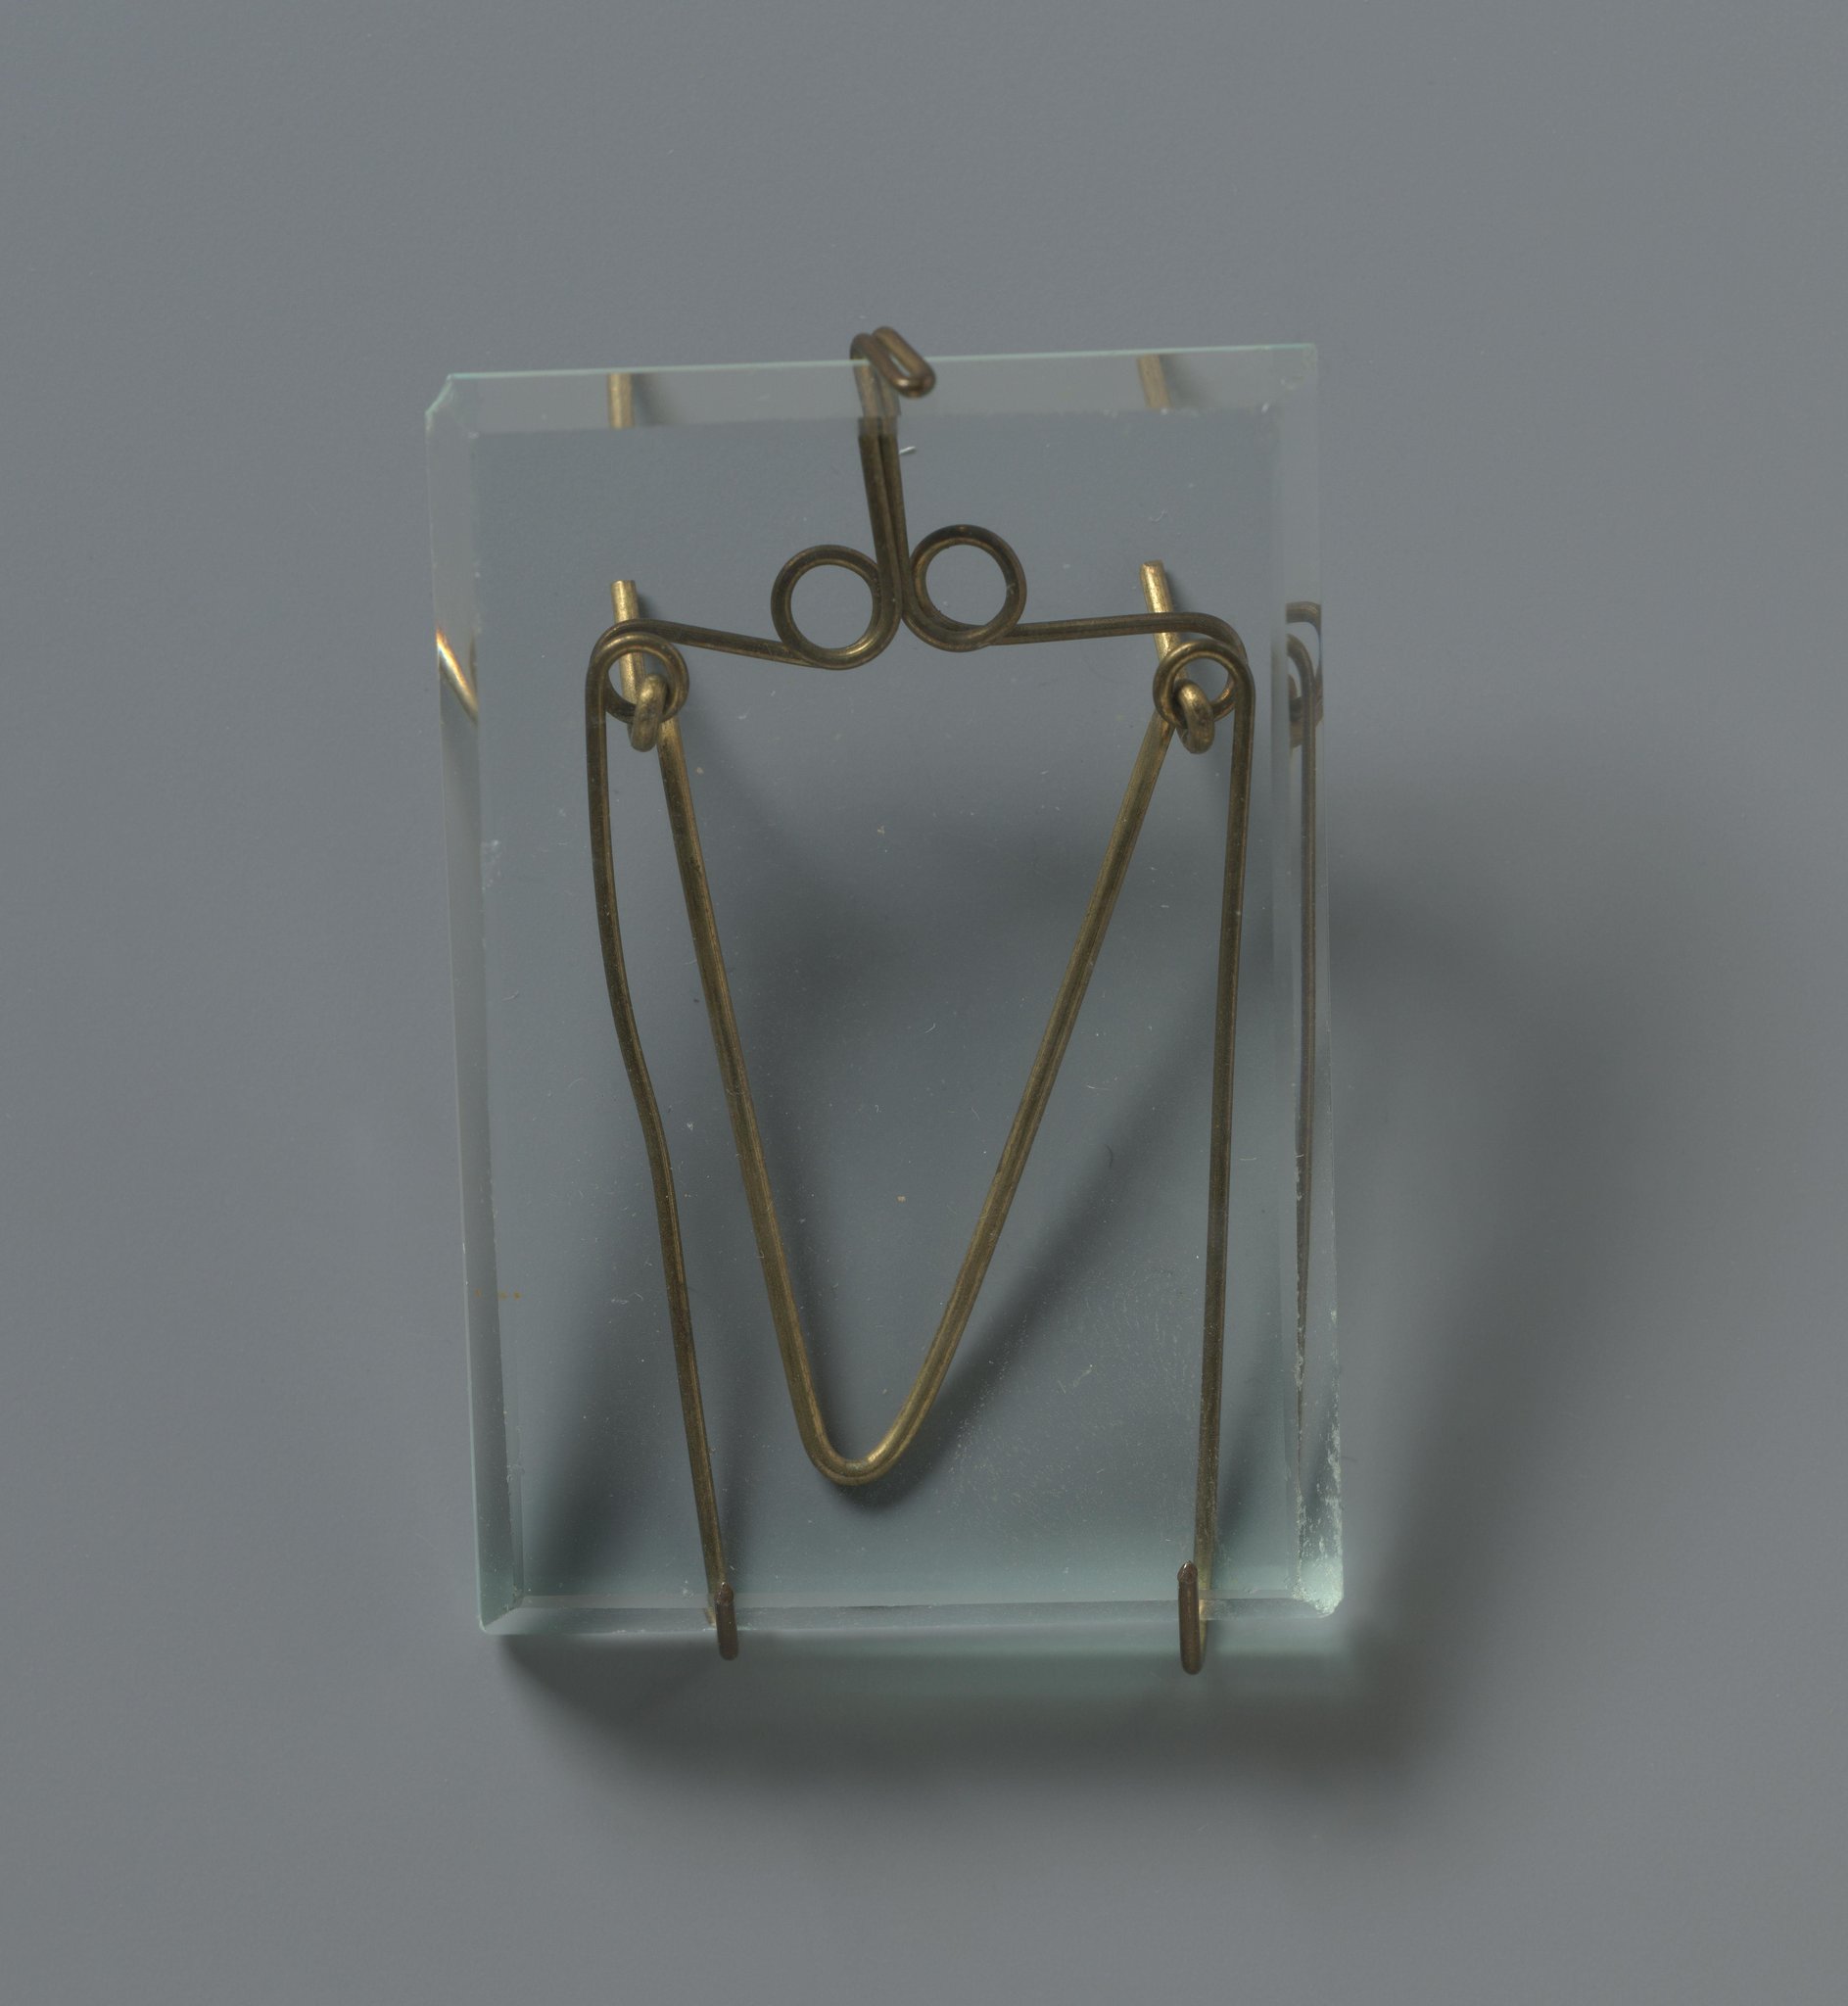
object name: frame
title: Lege miniatuurlijst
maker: Anonymous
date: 1890-1920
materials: glass, metal